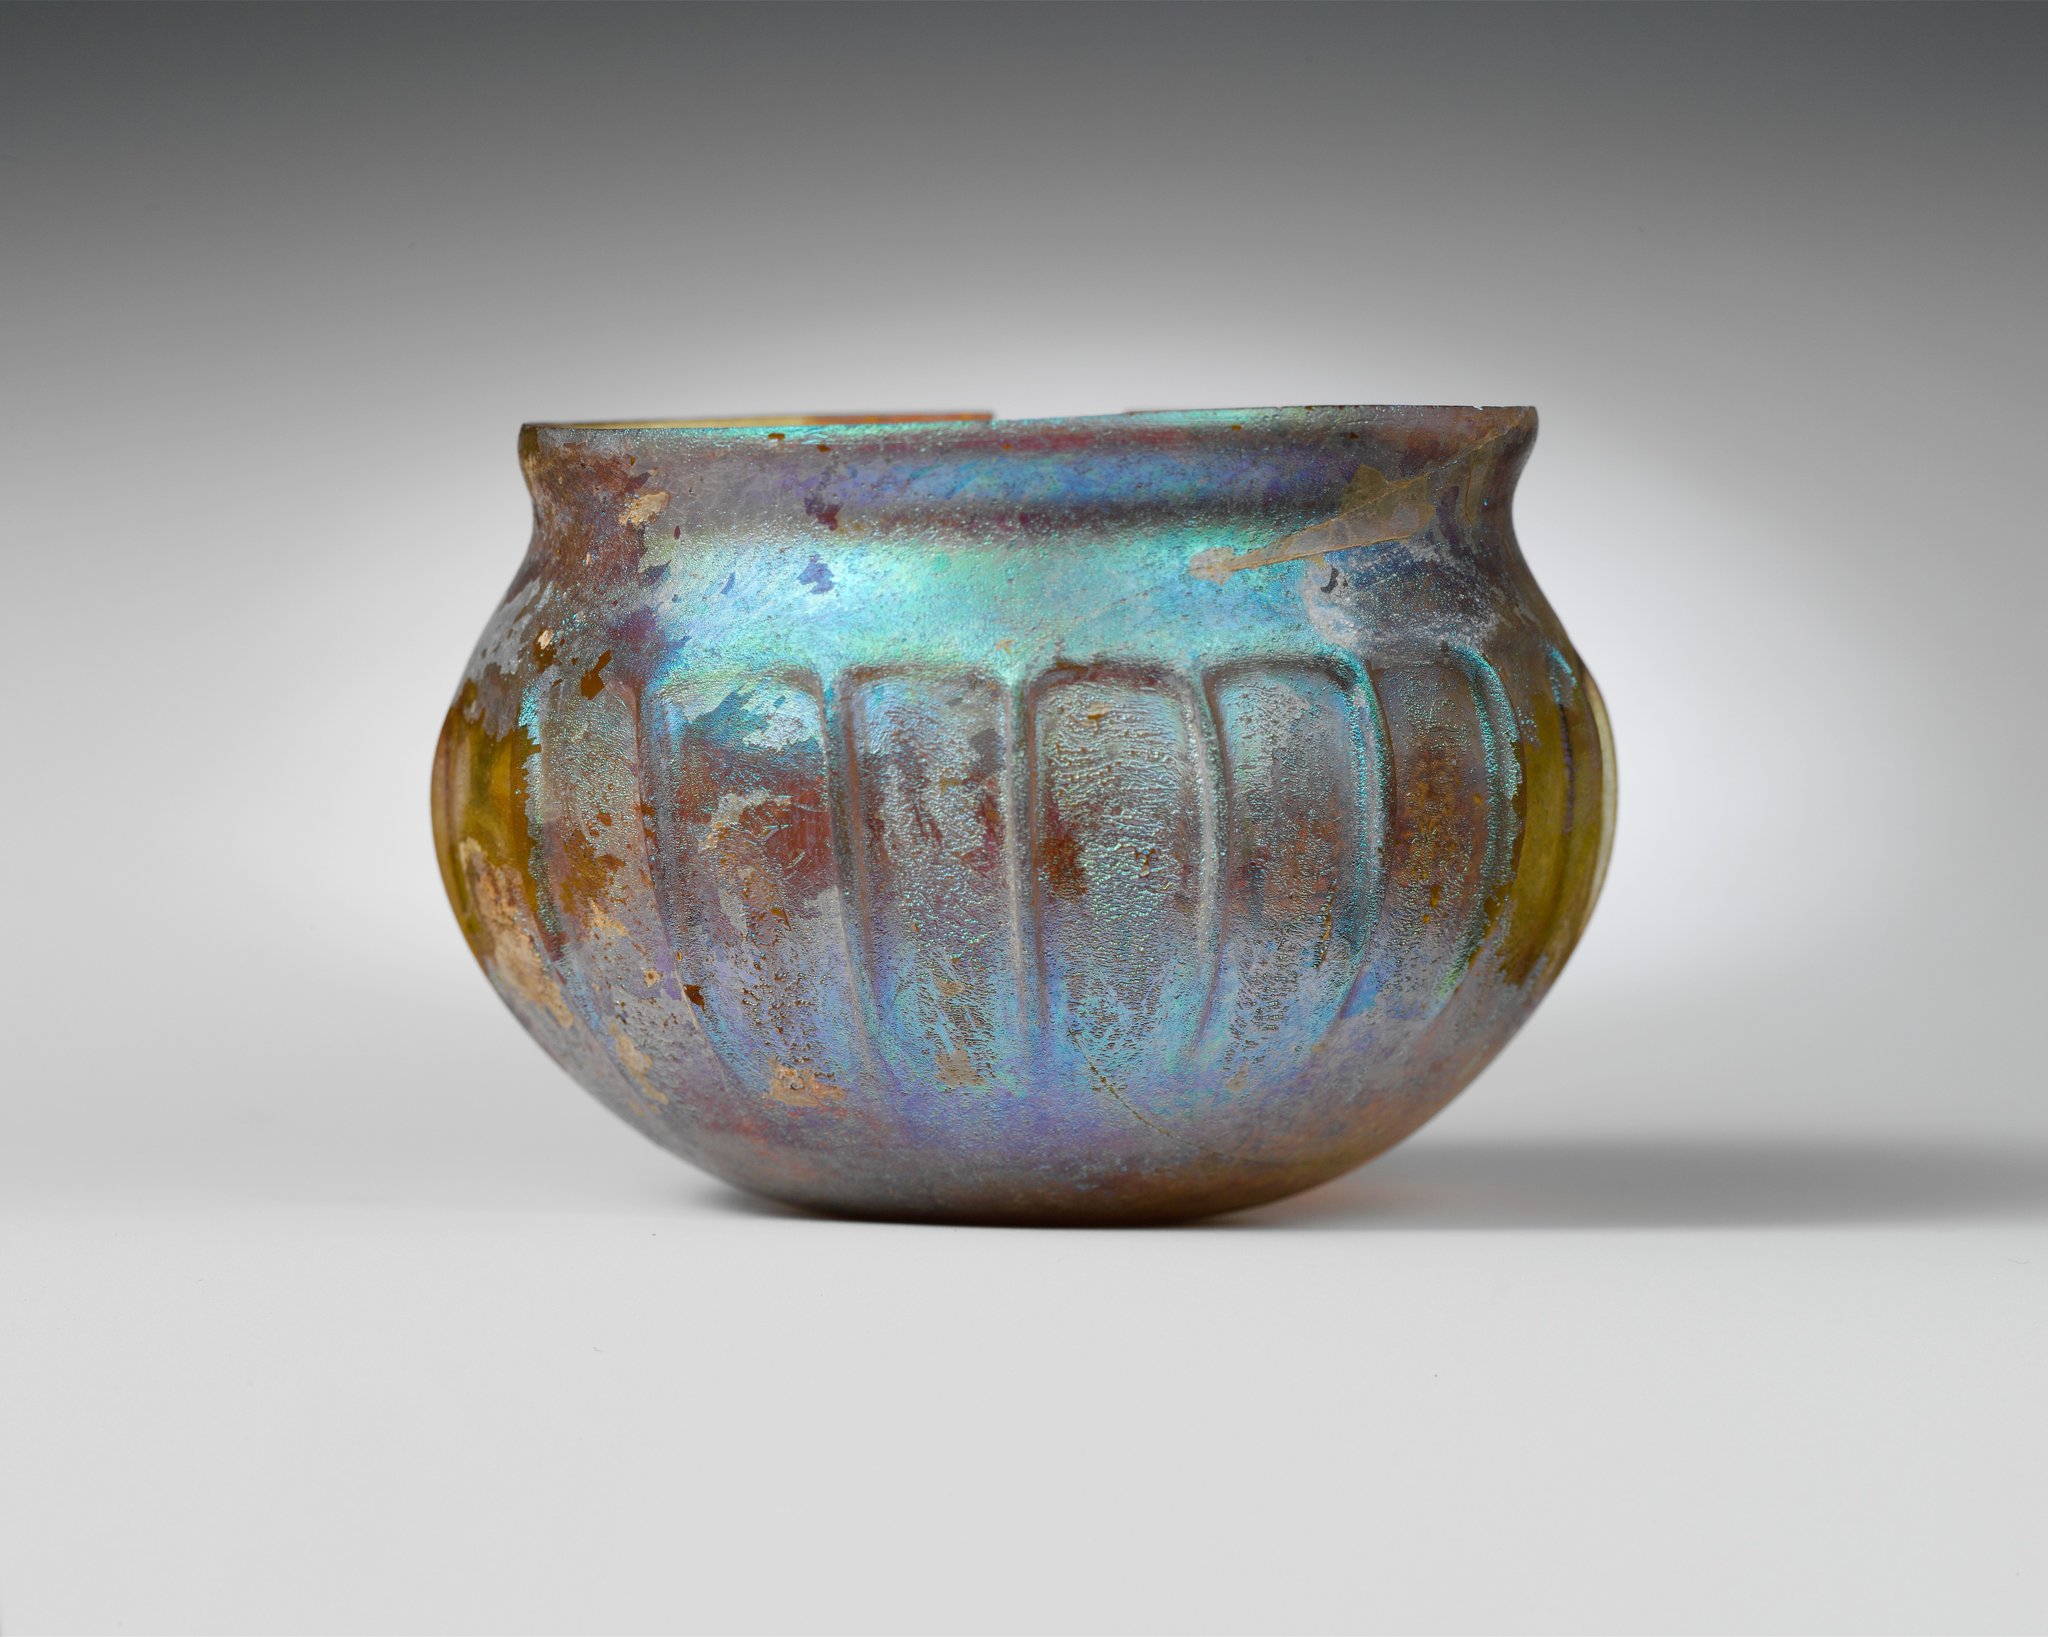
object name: bowl, rippenschale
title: Glass ribbed bowl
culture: roman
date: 34-66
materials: glass